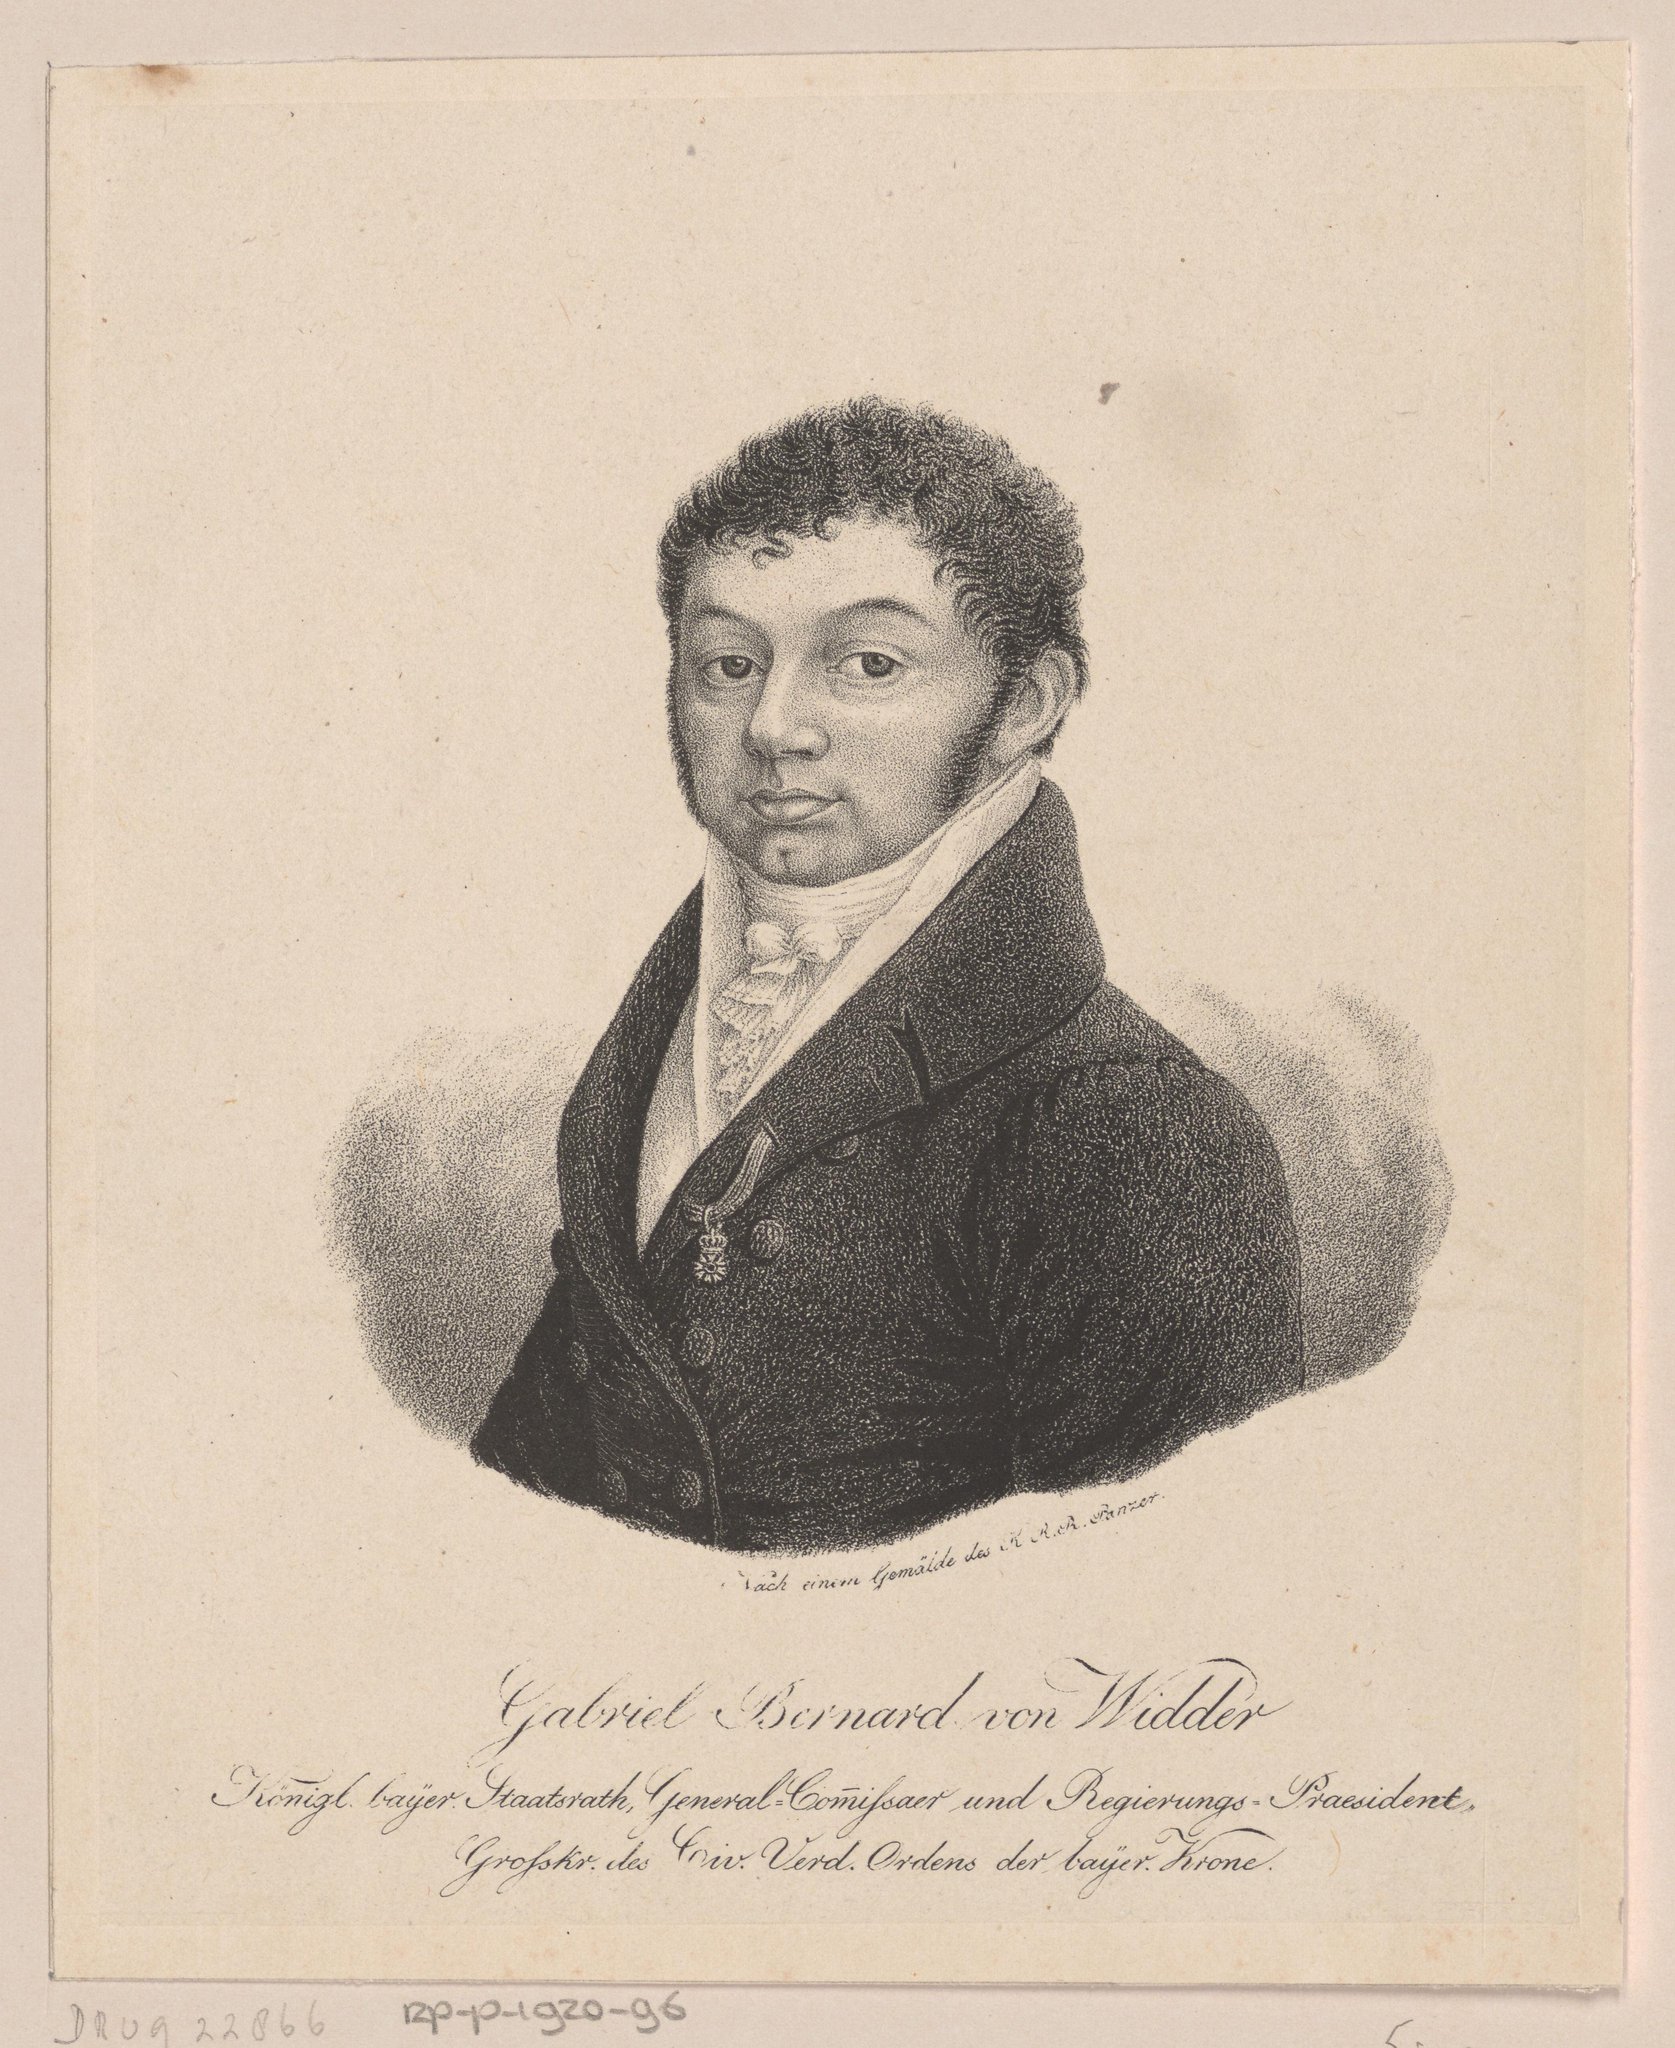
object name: print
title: Portret van Gabriel Bernhard von Widder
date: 1825-1870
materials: paper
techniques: lithograph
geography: germany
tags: historical persons, politician, e.g. party leader, medals and other marks of military honour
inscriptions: collector's mark: Lugt 2228